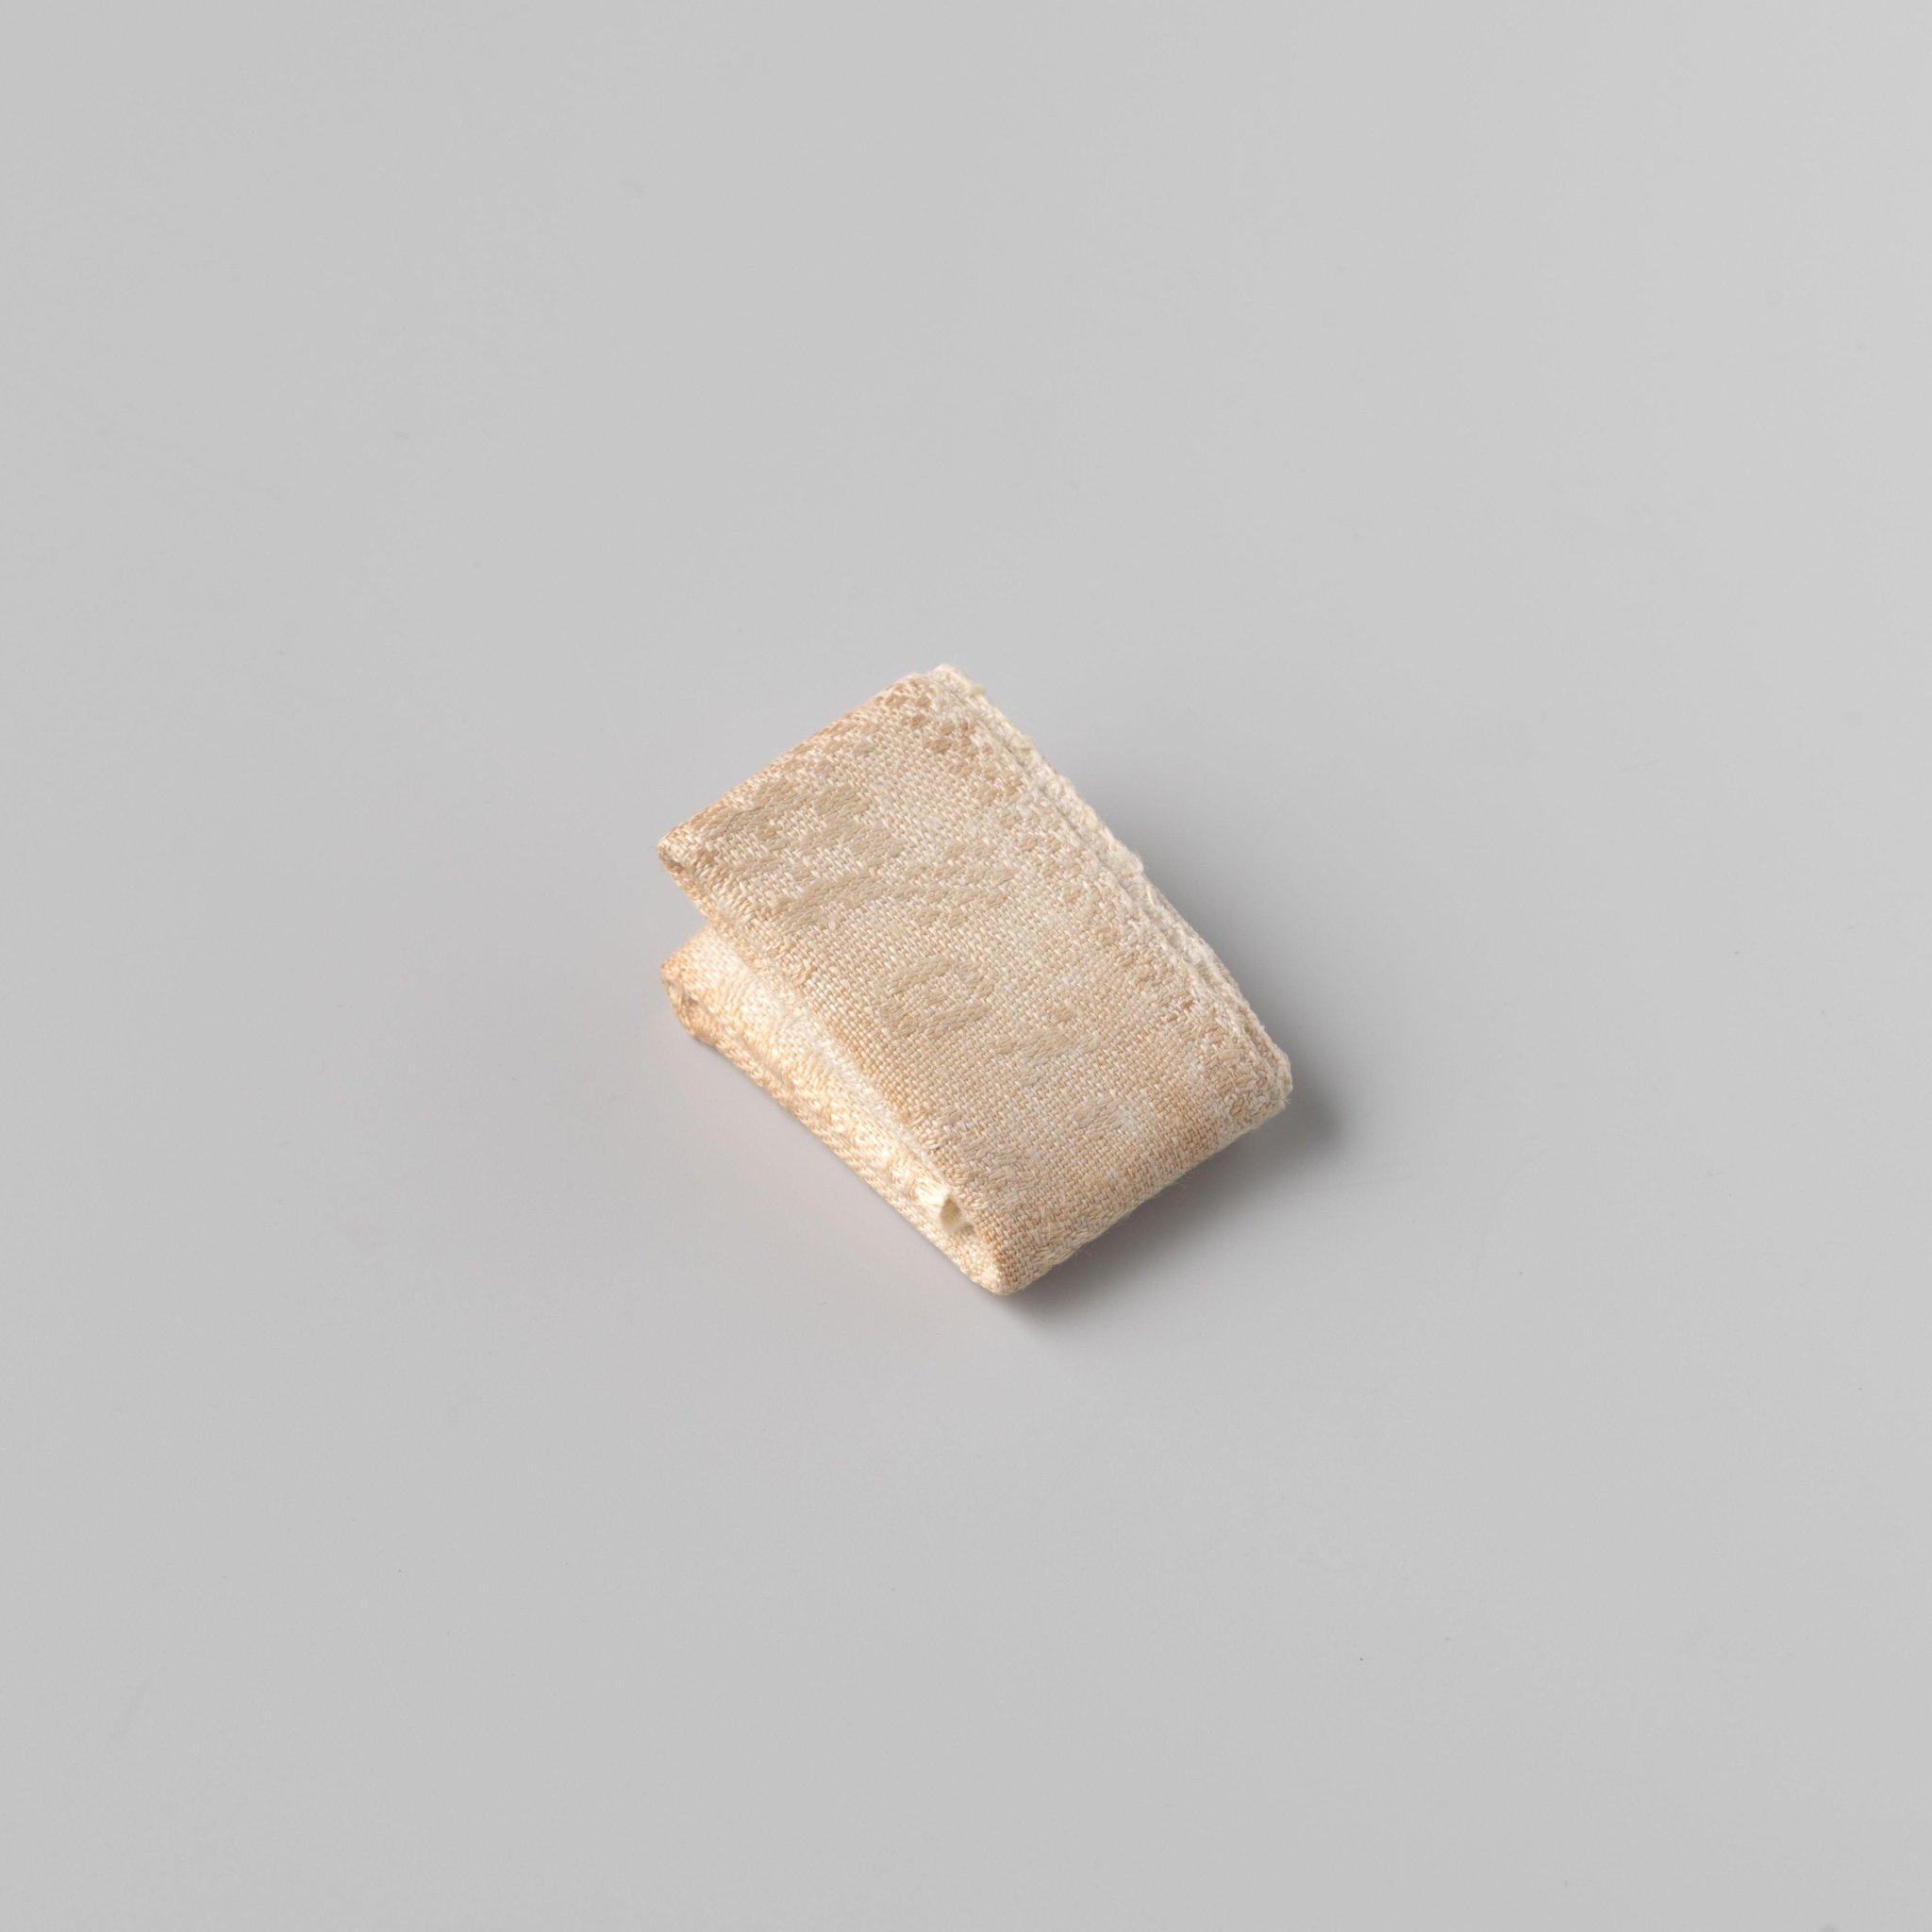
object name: dwaal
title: Linnen servet van damastweefsel, met centraal ingeweven monogram BO, waar boven en onder een vogel met opgeheven poot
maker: Anonymous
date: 1690-1710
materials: linen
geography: amsterdam